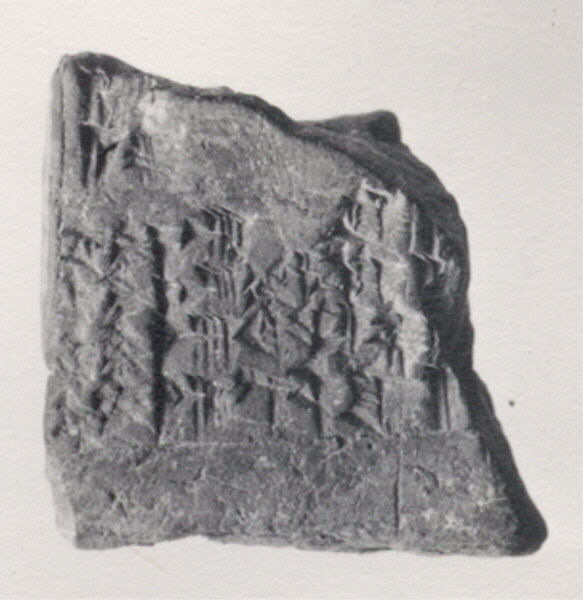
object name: cuneiform tablet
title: Cuneiform tablet: fragment of school exercise tablet, Urra=hubullu, tablets 14, 20, 21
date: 333-1 BCE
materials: clay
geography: mesopotamia